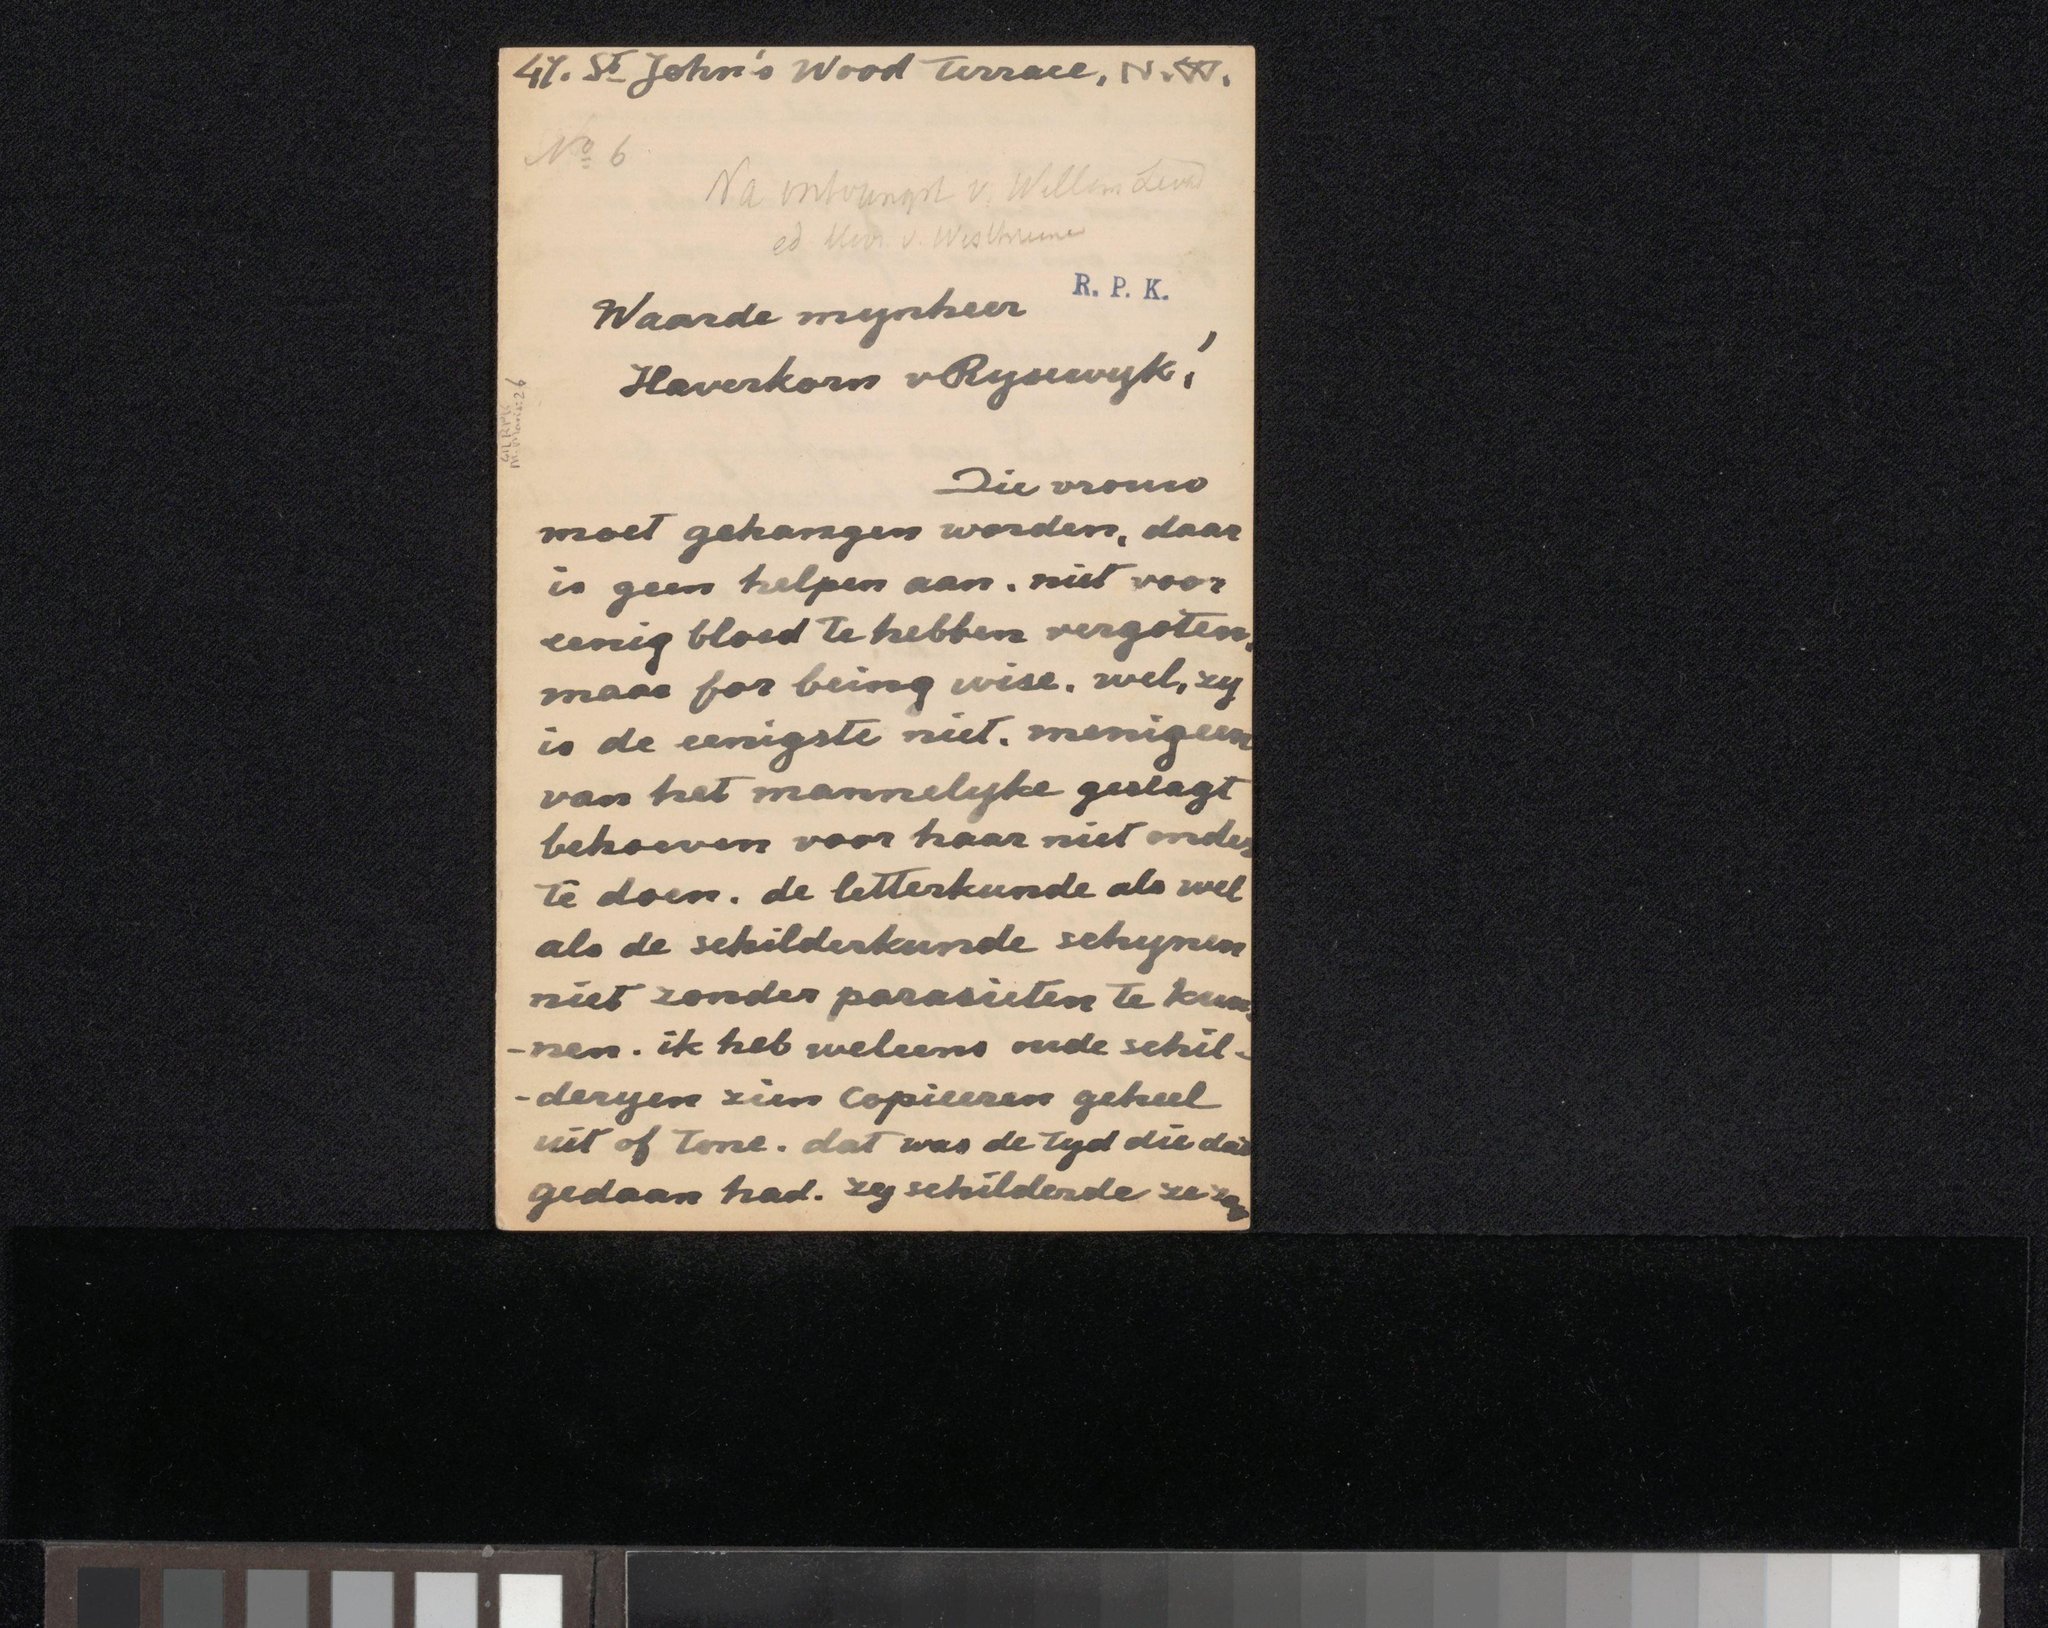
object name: letter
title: Brief aan Pieter Haverkorn van Rijsewijk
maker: matthijs maris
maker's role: draughtsman, painter, print maker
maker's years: 1839-1917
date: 1883-1915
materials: ink, paper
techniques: pen, writing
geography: london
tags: painter, print maker, draughtsman, vincent van gogh, london, john milton, pieter haverkorn van rijsewijk, robert burns, literature ~ arts, painting (including book-illumination, miniature-painting)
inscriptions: watermark, collector's mark: Lugt 2233